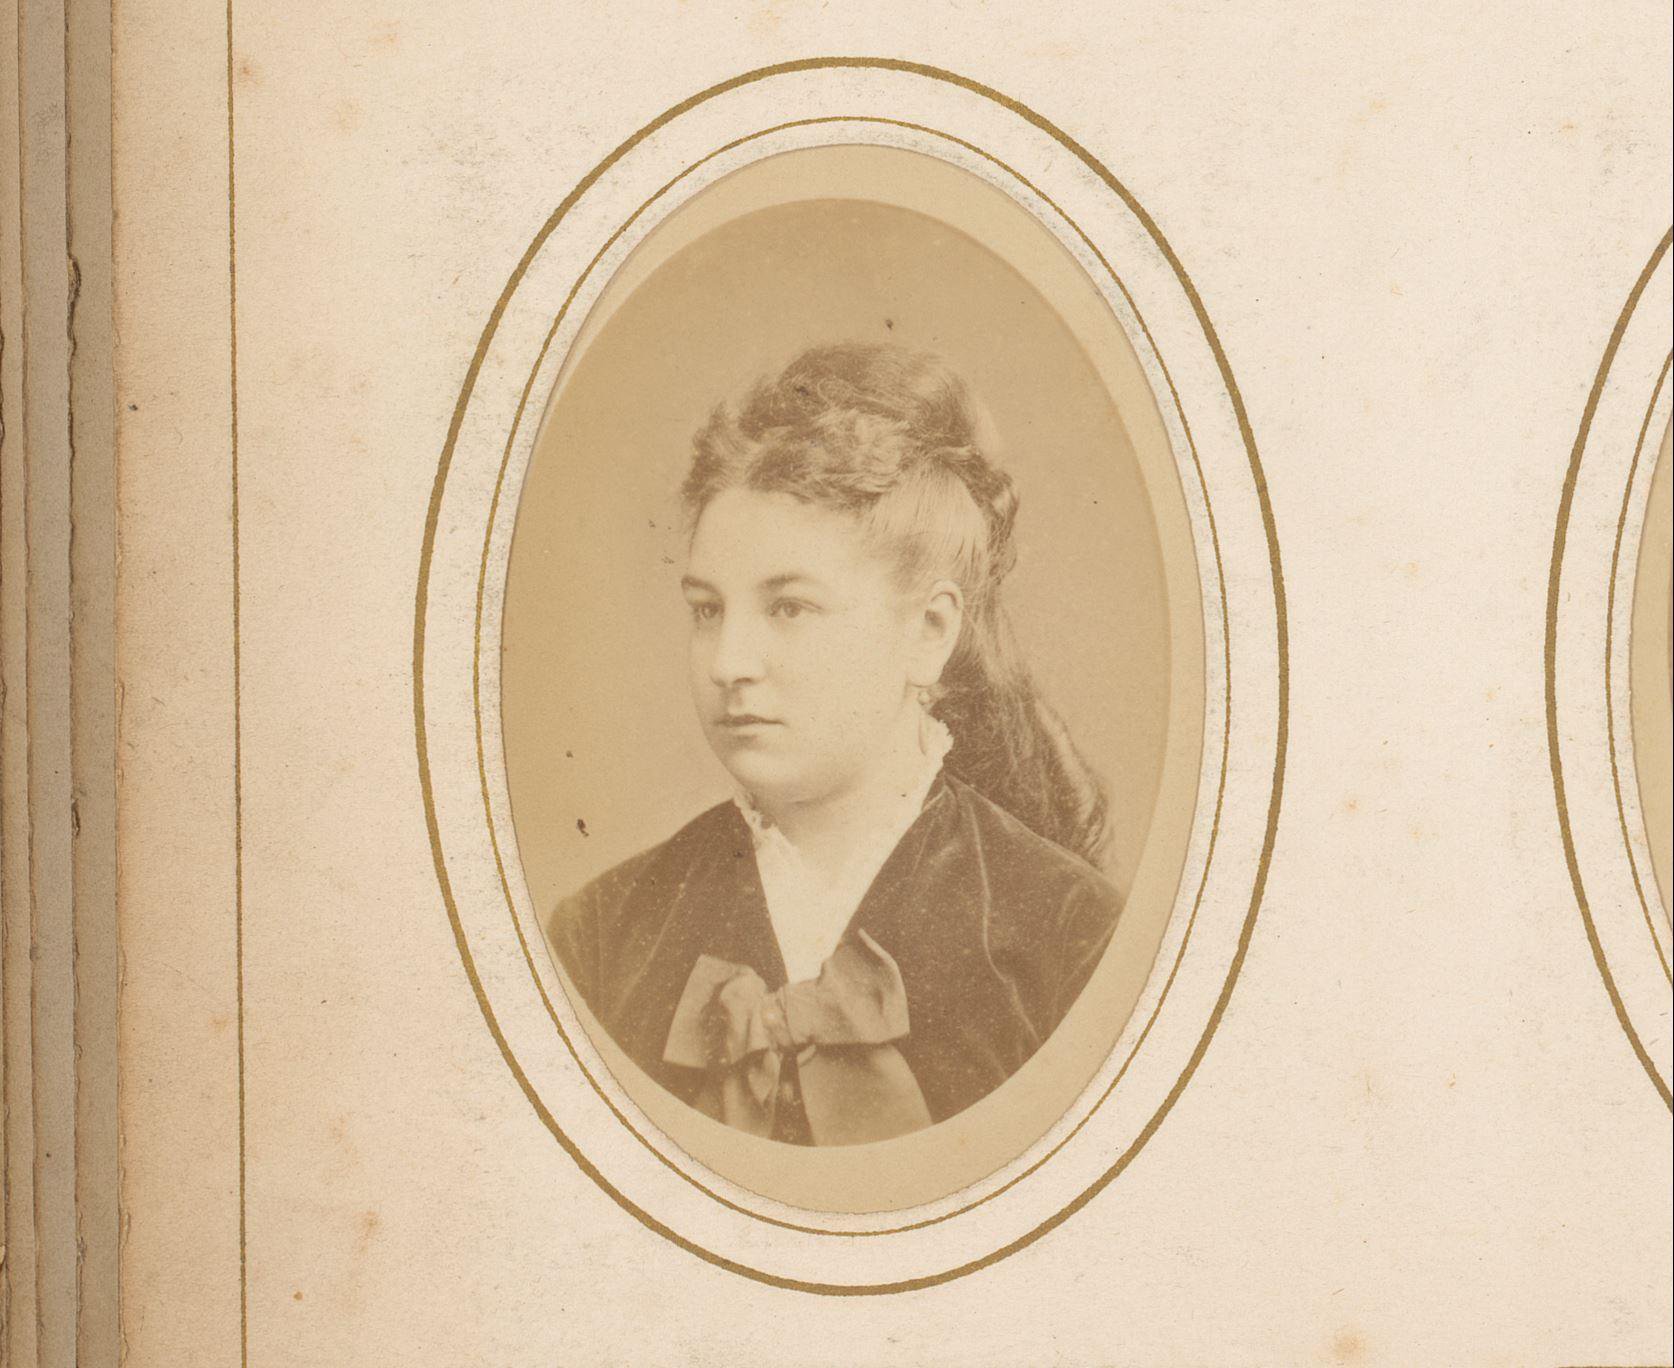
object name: album leaf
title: Portret van een jonge vrouw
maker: eugene guérin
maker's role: fotograaf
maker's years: 1845-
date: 1875-1885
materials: cardboard, photographic support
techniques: albumen print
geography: brussels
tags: adolescent, young woman, maiden, historical persons - bb - woman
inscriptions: inscription: ‘Eugène Guérin/ 142, Rue Royale, 142./ BRUXELLES’